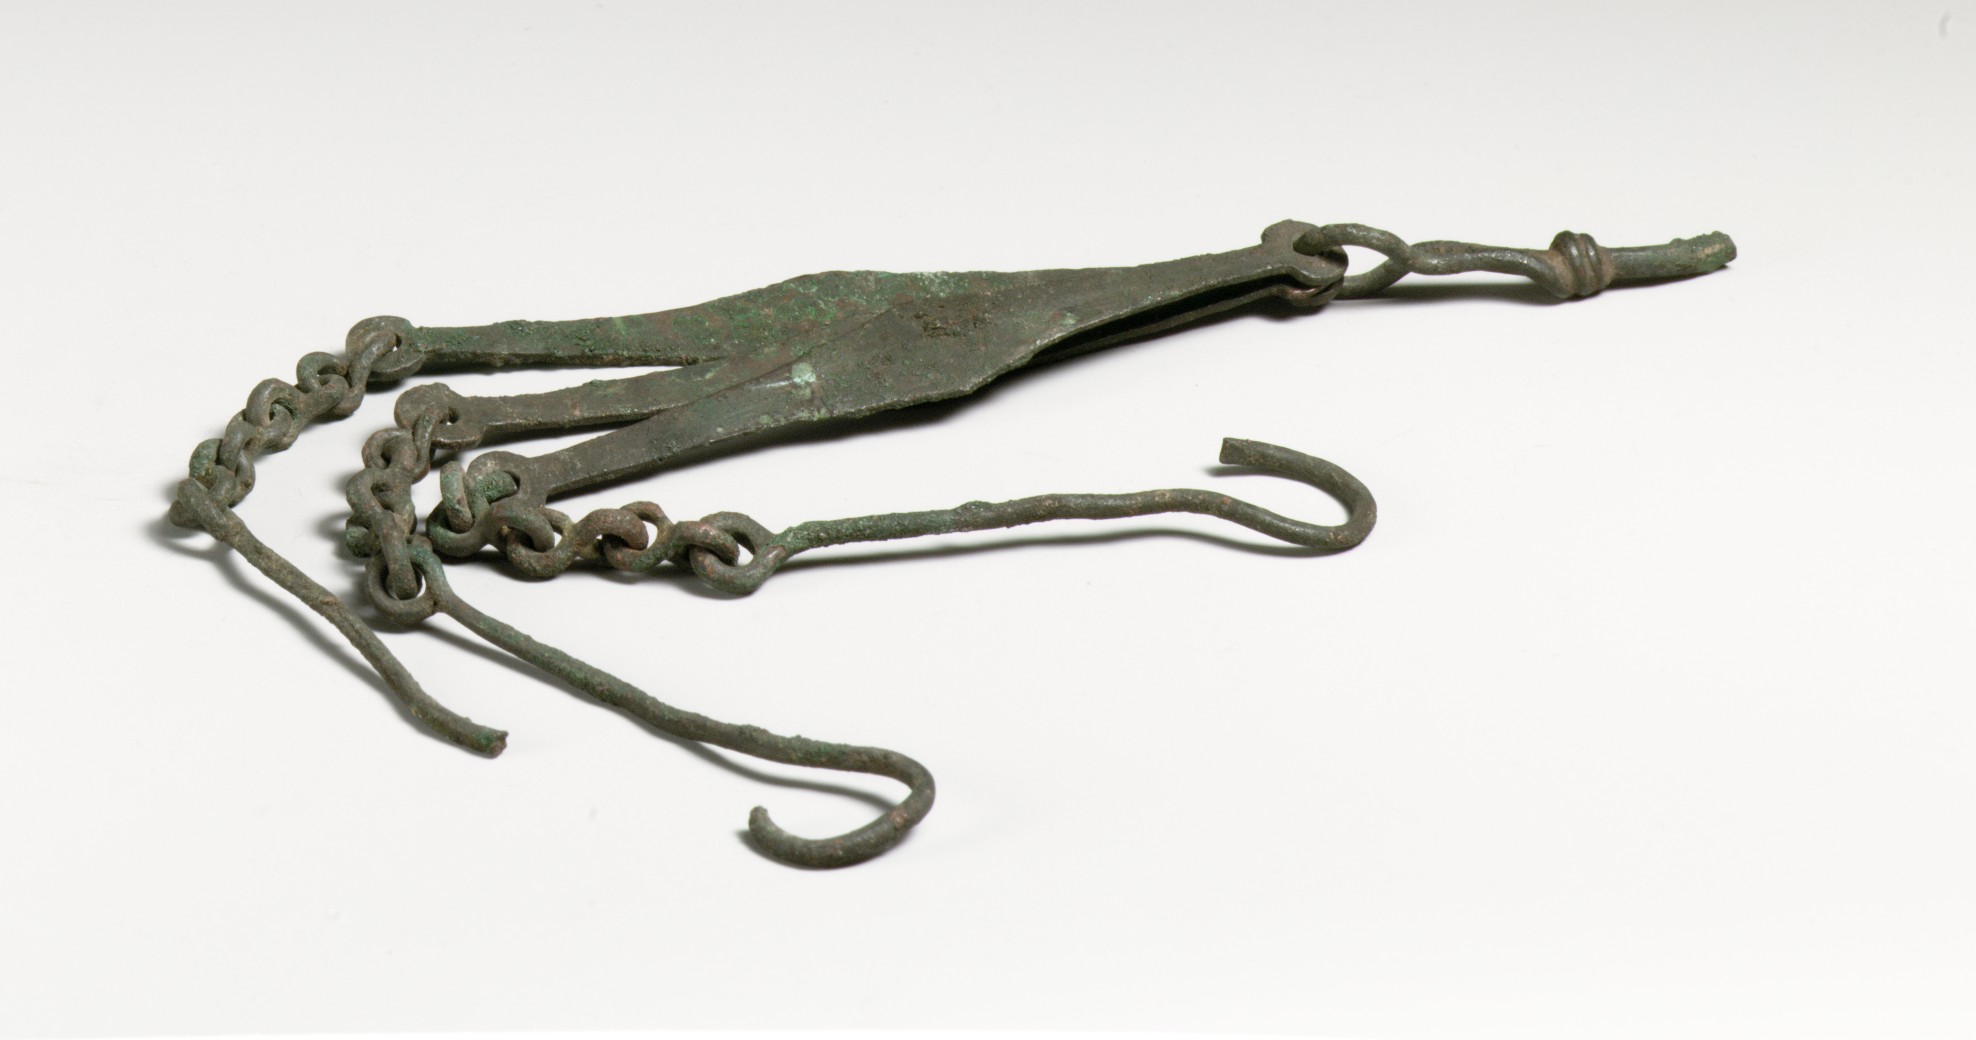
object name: chain, 3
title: Chains, 3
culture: cypriot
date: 3900 BCE-100 CE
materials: bronze